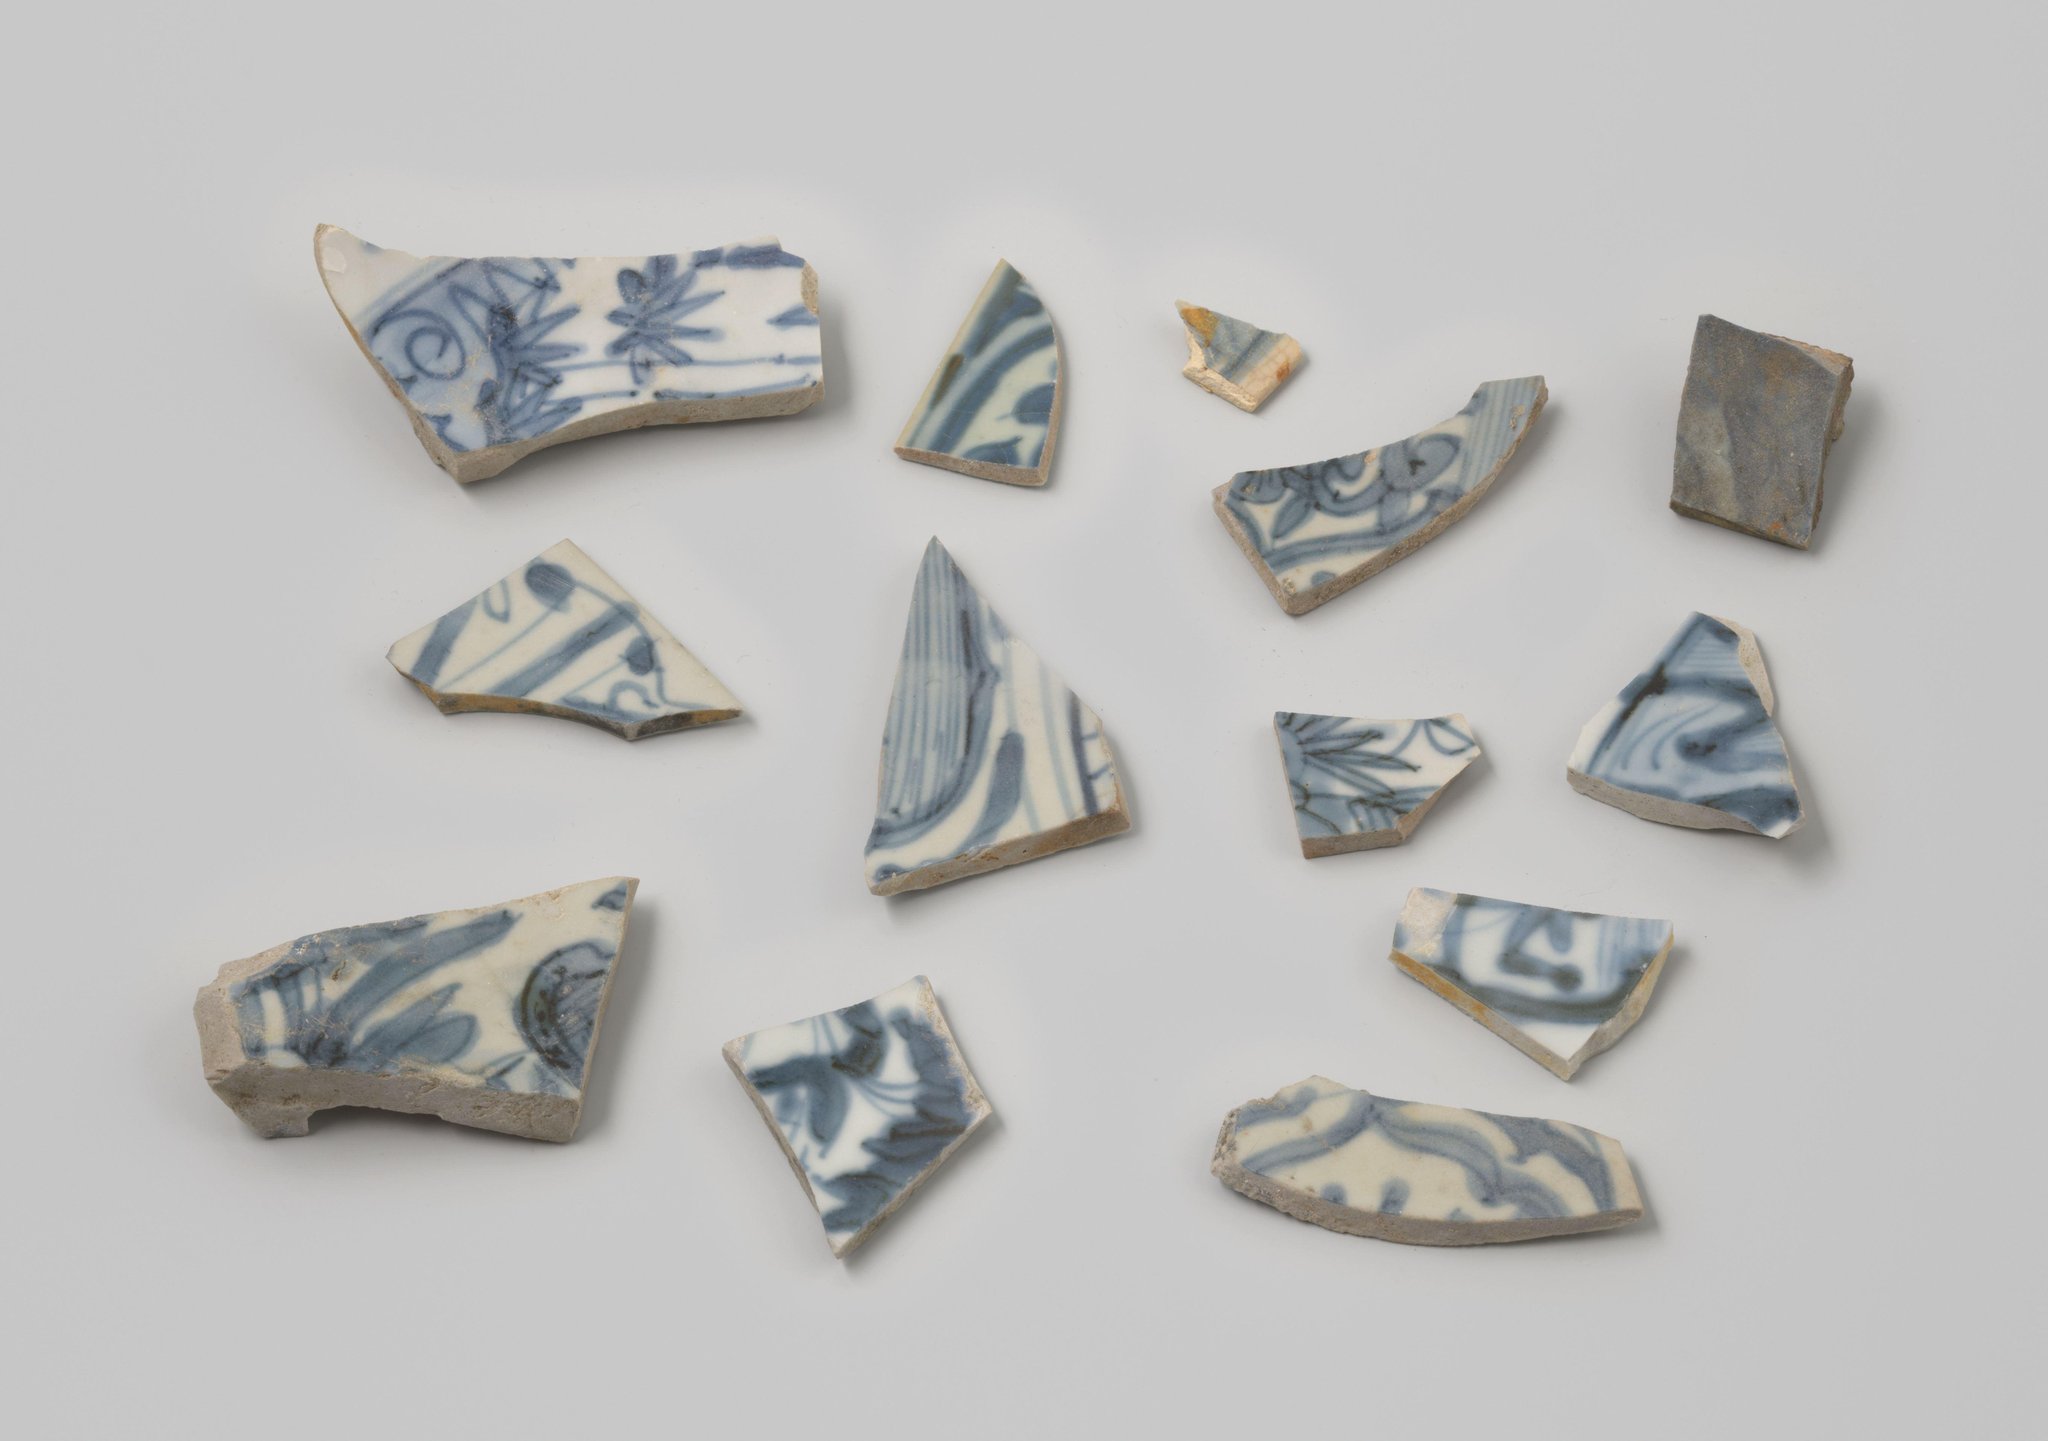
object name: plate dish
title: Scherven van borden uit V.O.C.-schip de 'Witte Leeuw'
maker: Anonymous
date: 1613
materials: bone china, porcelain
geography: shantou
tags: verenigde oostindische compagnie, sint-helena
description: A large dish. In the centre a water landscape with ducks. On the walls medallions with a white frame edged with blue in which a floral design is painted. These are separared by 9 narrow bands. On the outside are two wavy ribbons and a thin band around the lip-rim.